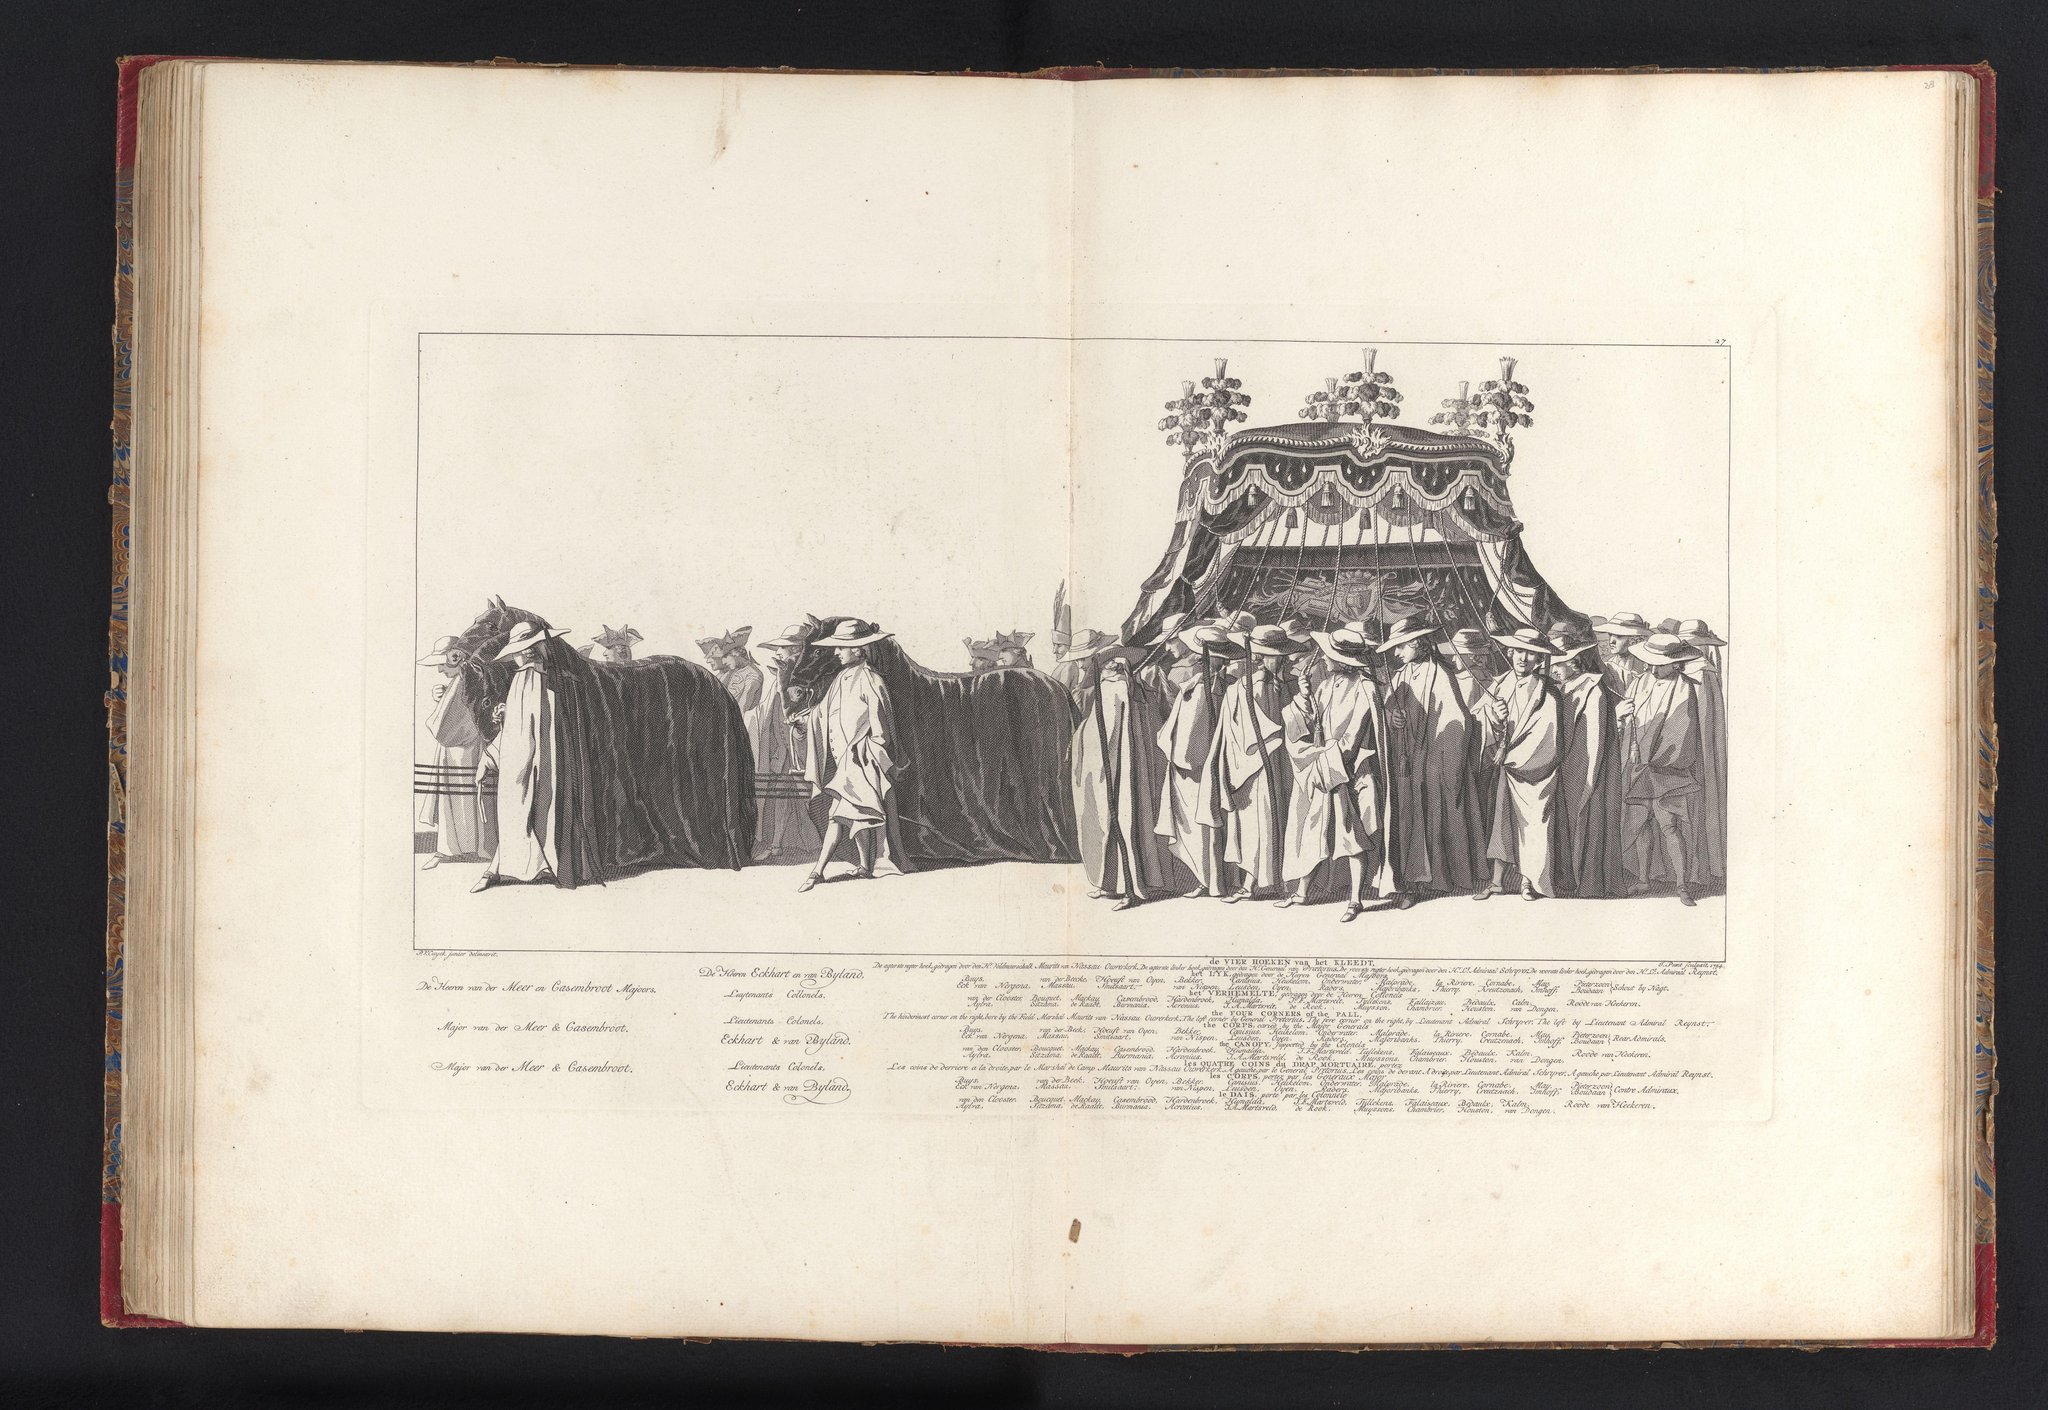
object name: album leaf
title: Lyk-staetsie van zyne doorluchtigste Hoogheid den Heere Willem Carel Hendrik Friso, Prince van Orange en Nassau (...) gehouden den IV Februari 1752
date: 1754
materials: paper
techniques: engraving, etching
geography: the hague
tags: the hague, willem iv (prins van oranje-nassau), funeral carriages, cortege, funeral procession, royal household; courtiers, retinue, train, delft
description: Leden van de stadhouderlijke huishouding gevolgd door twee spannen paarden met de lijkwagen en de dragers. In de marge een onderschrift in het Nederlands, Frans en Engels. De prent maakt deel uit van een album.